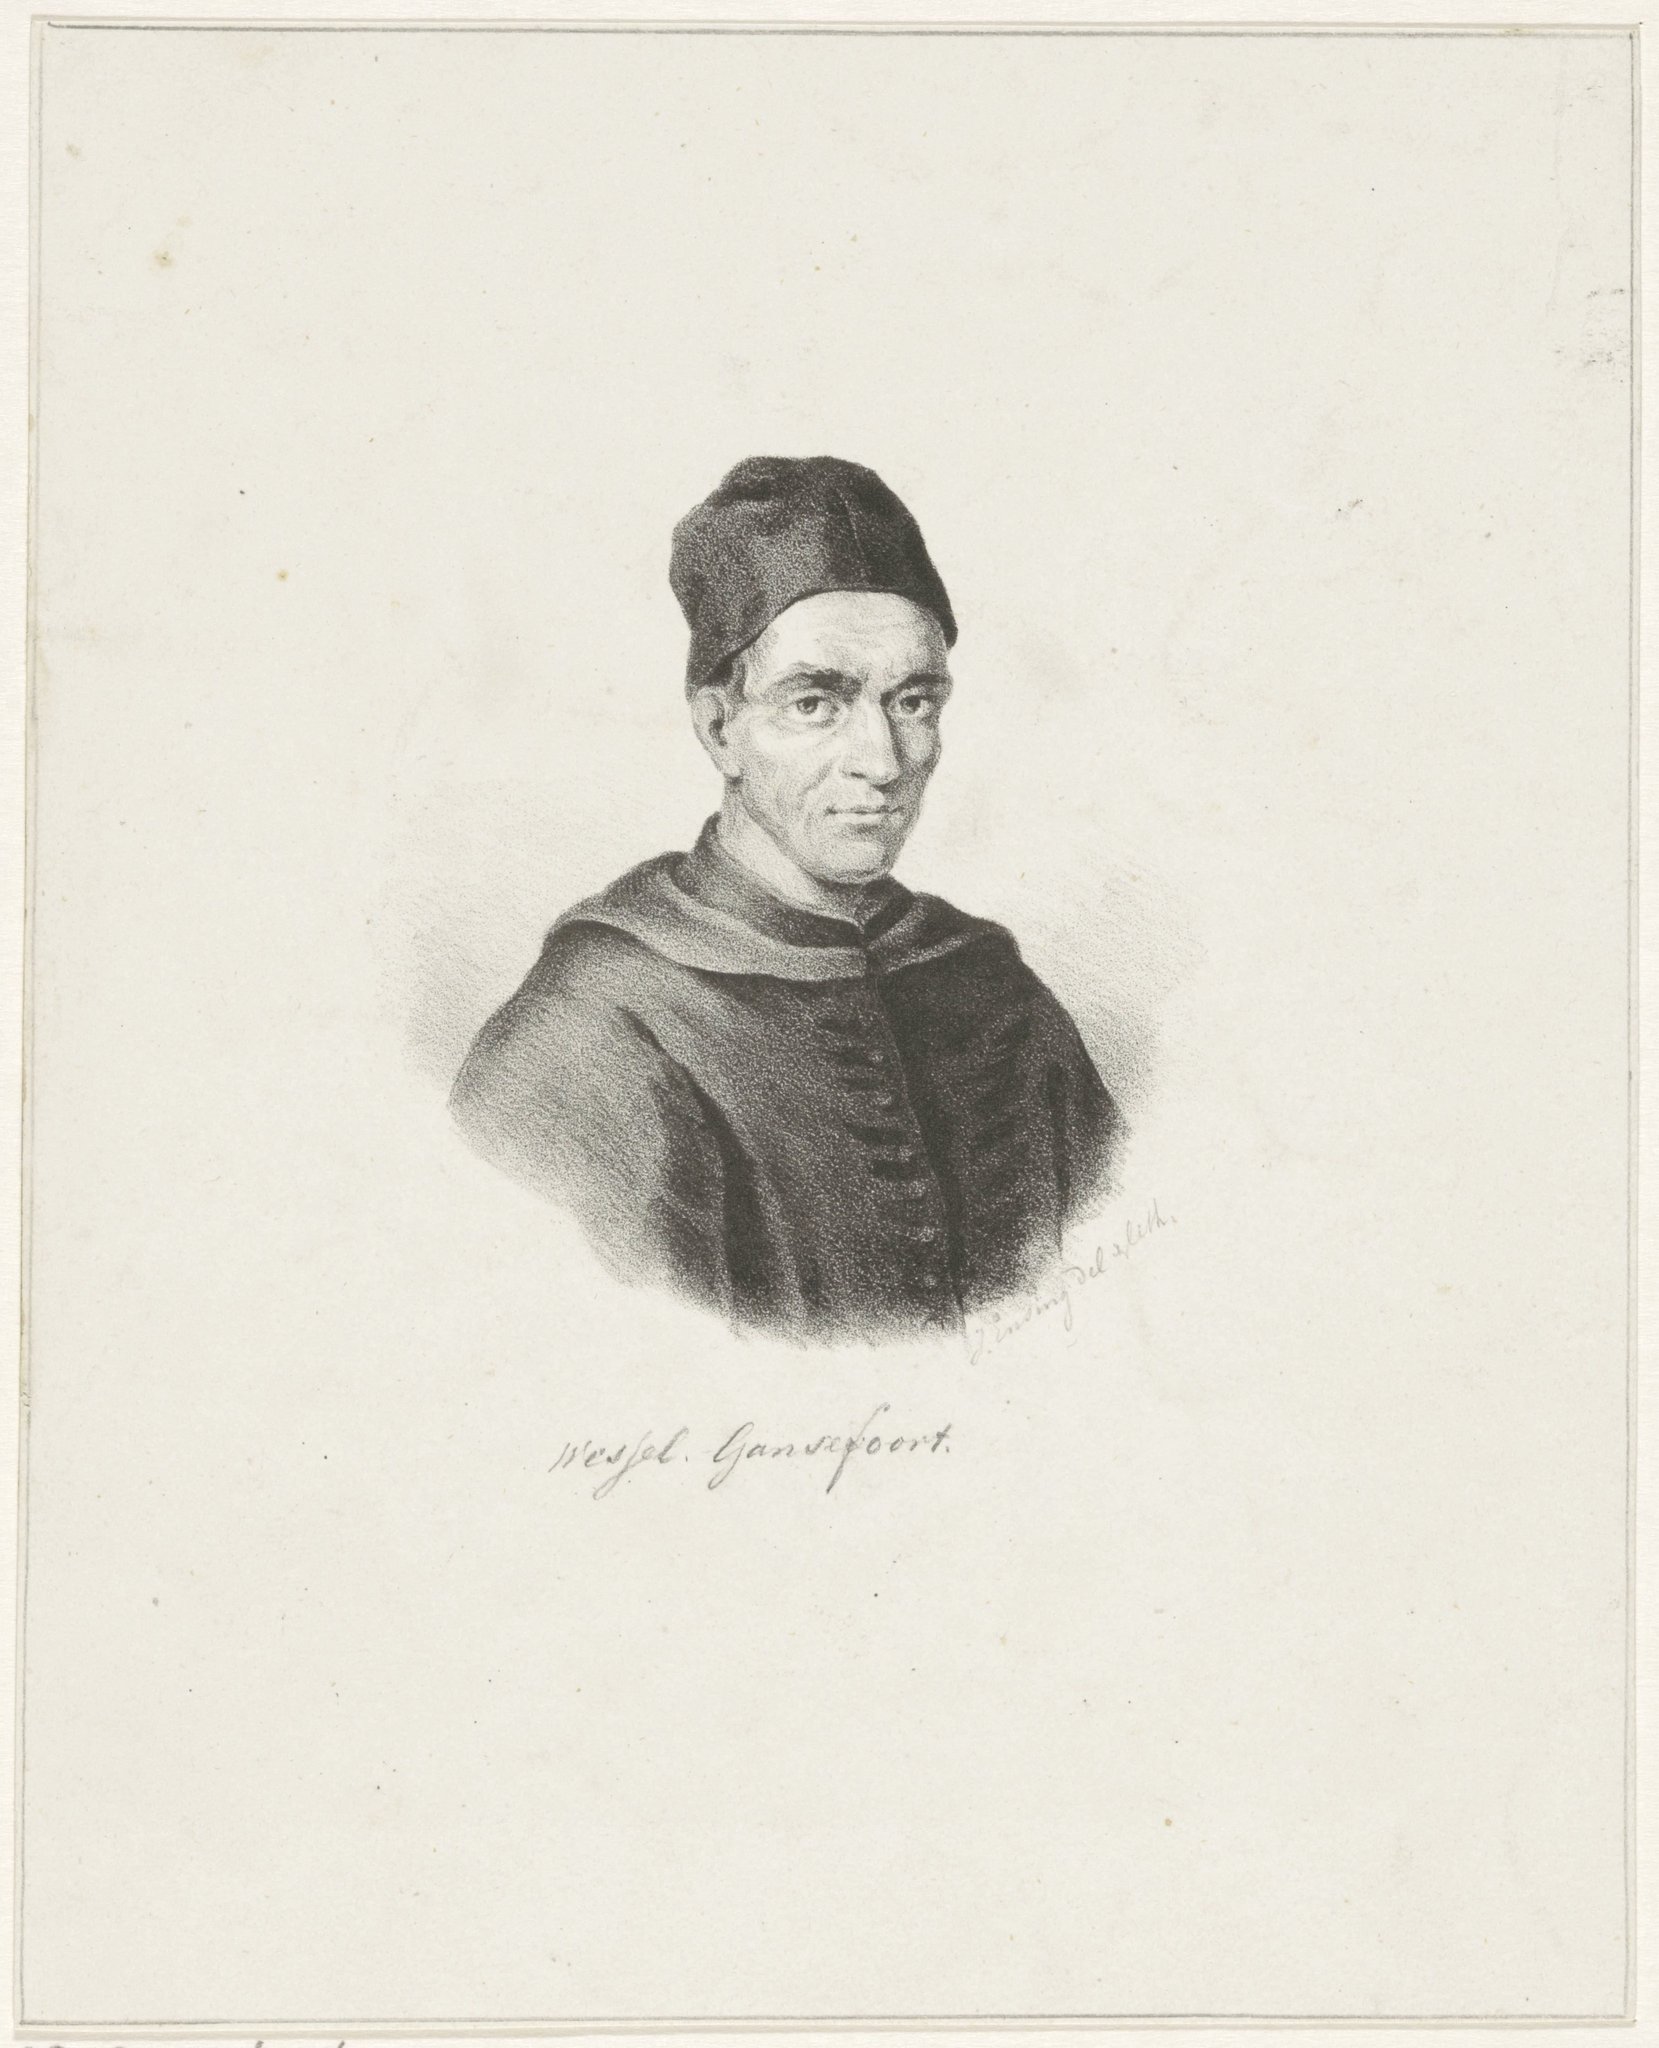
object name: print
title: Portret van Johan Wessel Gansfort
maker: jan ensing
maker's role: draughtsman, painter, print maker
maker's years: 1819-1894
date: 1829-1894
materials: paper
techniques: lithograph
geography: groningen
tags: head-gear: cap, historical persons (+ (full) bust portrait)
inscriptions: collector's mark: Lugt 2228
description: De geportretteerde zit naar rechts gedraaid. Hij draagt een muts. Onder het portret zijn naam.